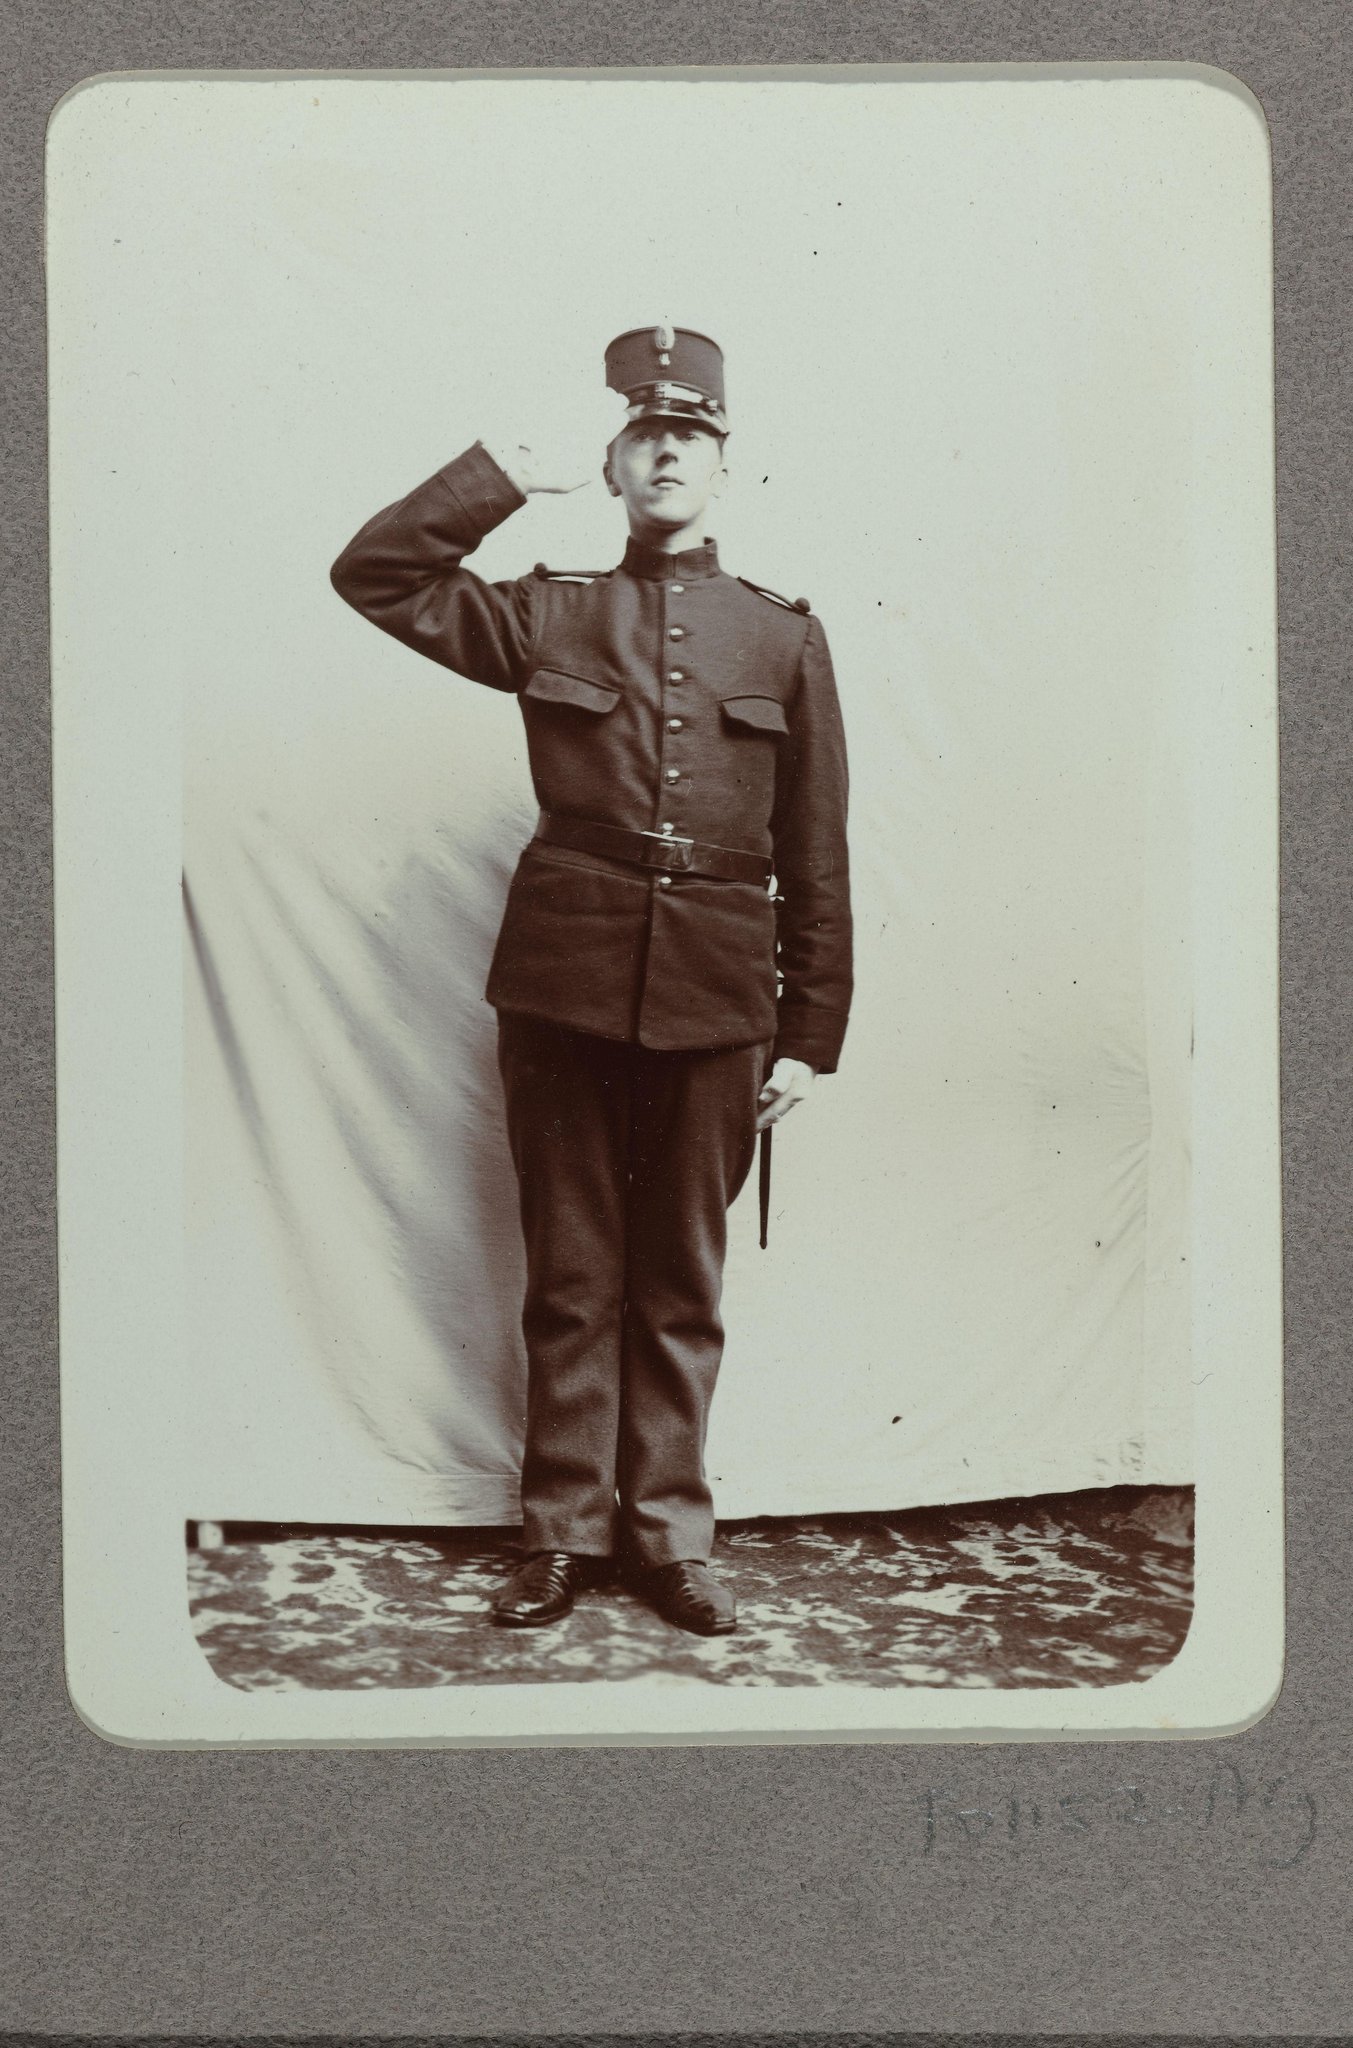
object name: photograph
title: Portret van een saluerende man in uniform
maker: christiaan otto roelofs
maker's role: fotograaf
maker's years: 1882-1970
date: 1900-1915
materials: photographic support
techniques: gelatin silver print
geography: netherlands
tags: adult man, historical persons, (military) uniforms